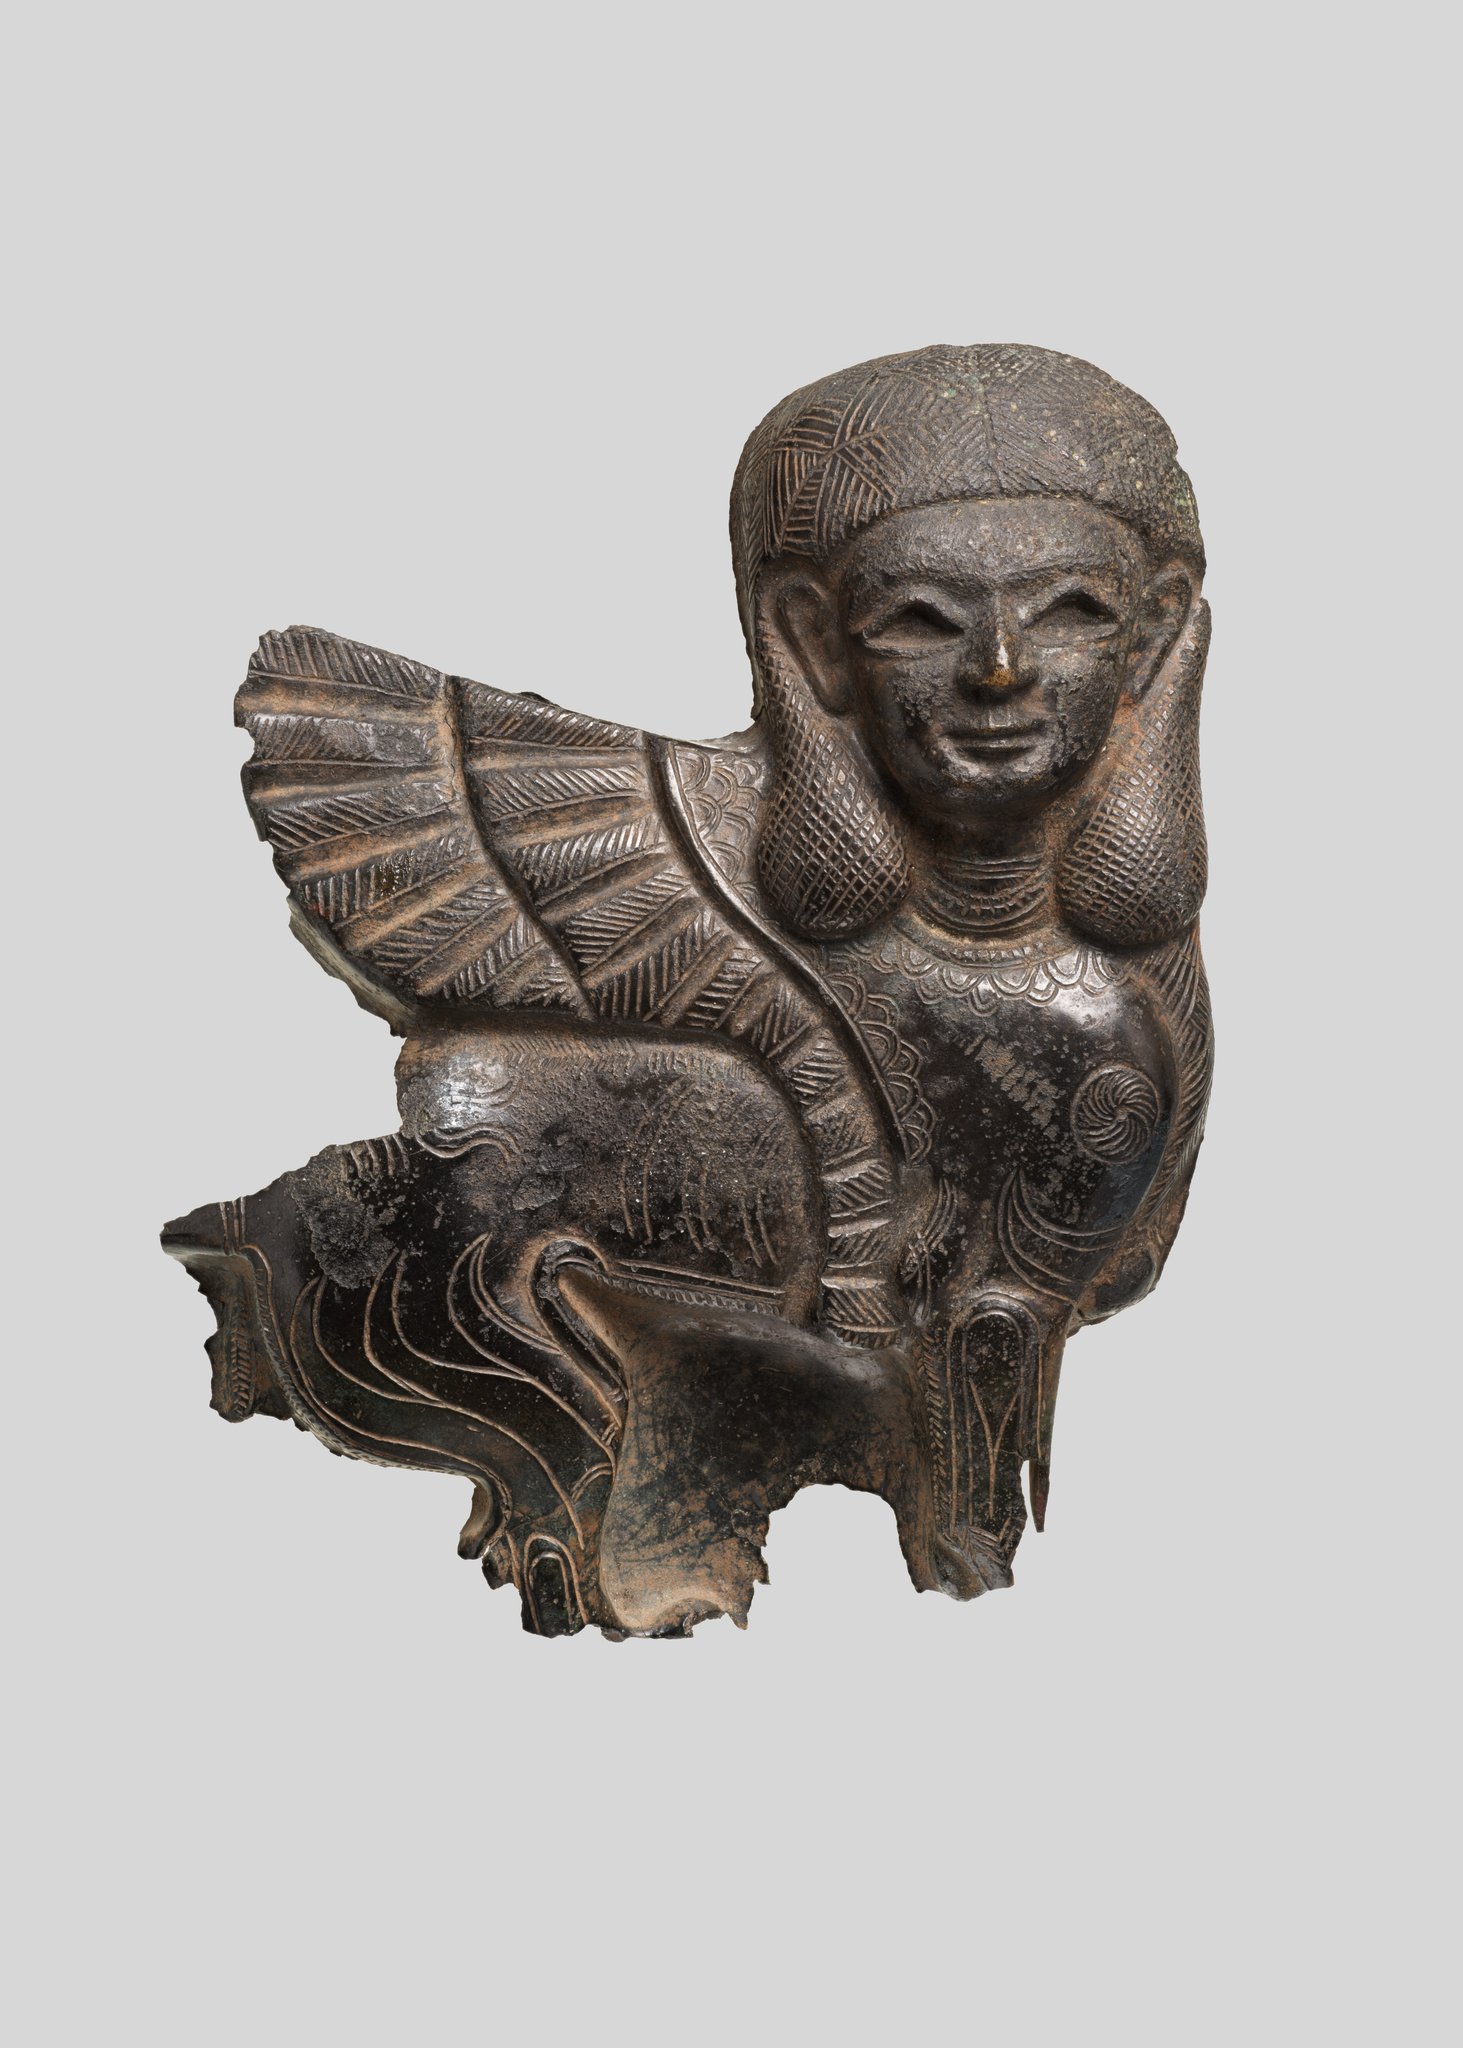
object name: relief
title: Plaque in the form of a sphinx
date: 800-701 BCE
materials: bronze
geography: syria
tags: sphinx